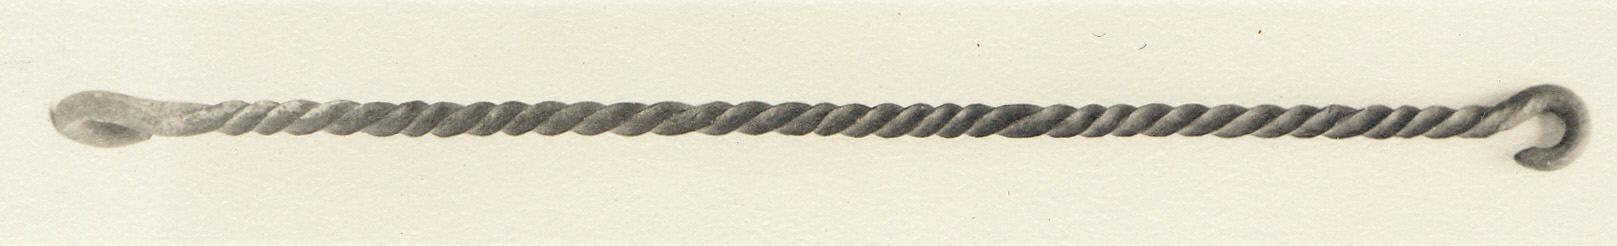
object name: support bar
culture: french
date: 1600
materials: iron